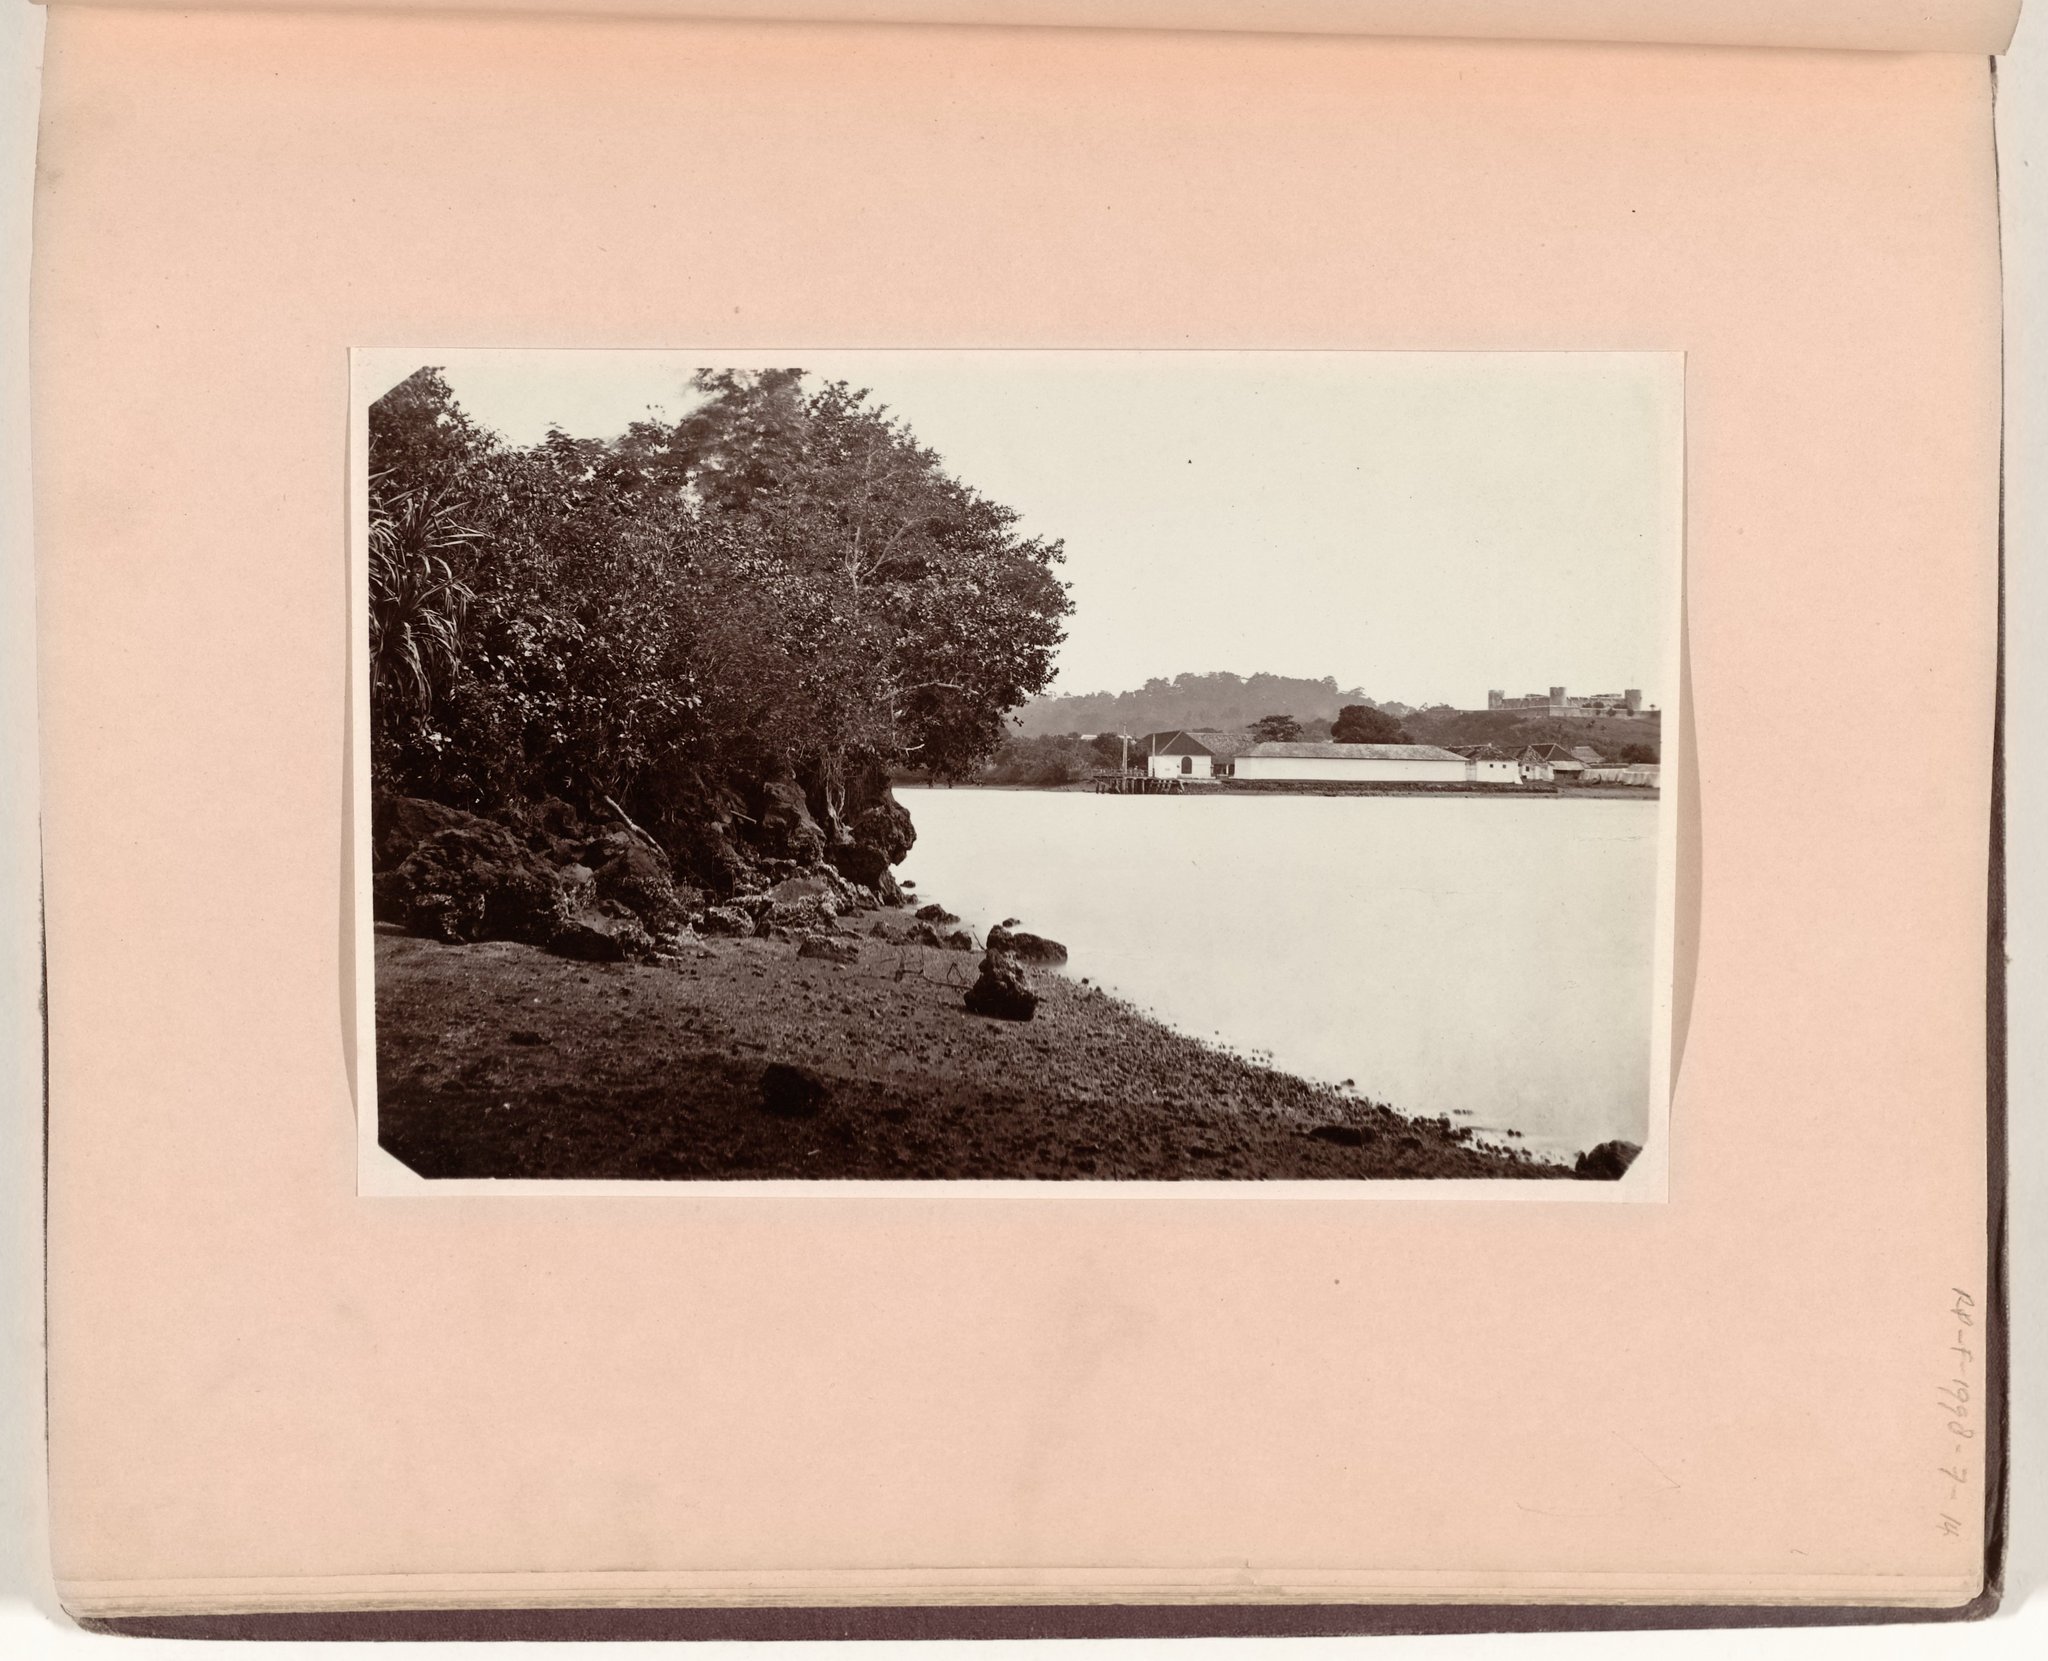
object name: photograph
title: Gezicht op pakhuizen voor nootmuskaat op Bandaneira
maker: c. dietrich (fotograaf)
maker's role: fotograaf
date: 1875-1890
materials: cardboard, paper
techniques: albumen print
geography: banda neira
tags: large-scale structure for storage, e.g.: warehouse, depot, silo